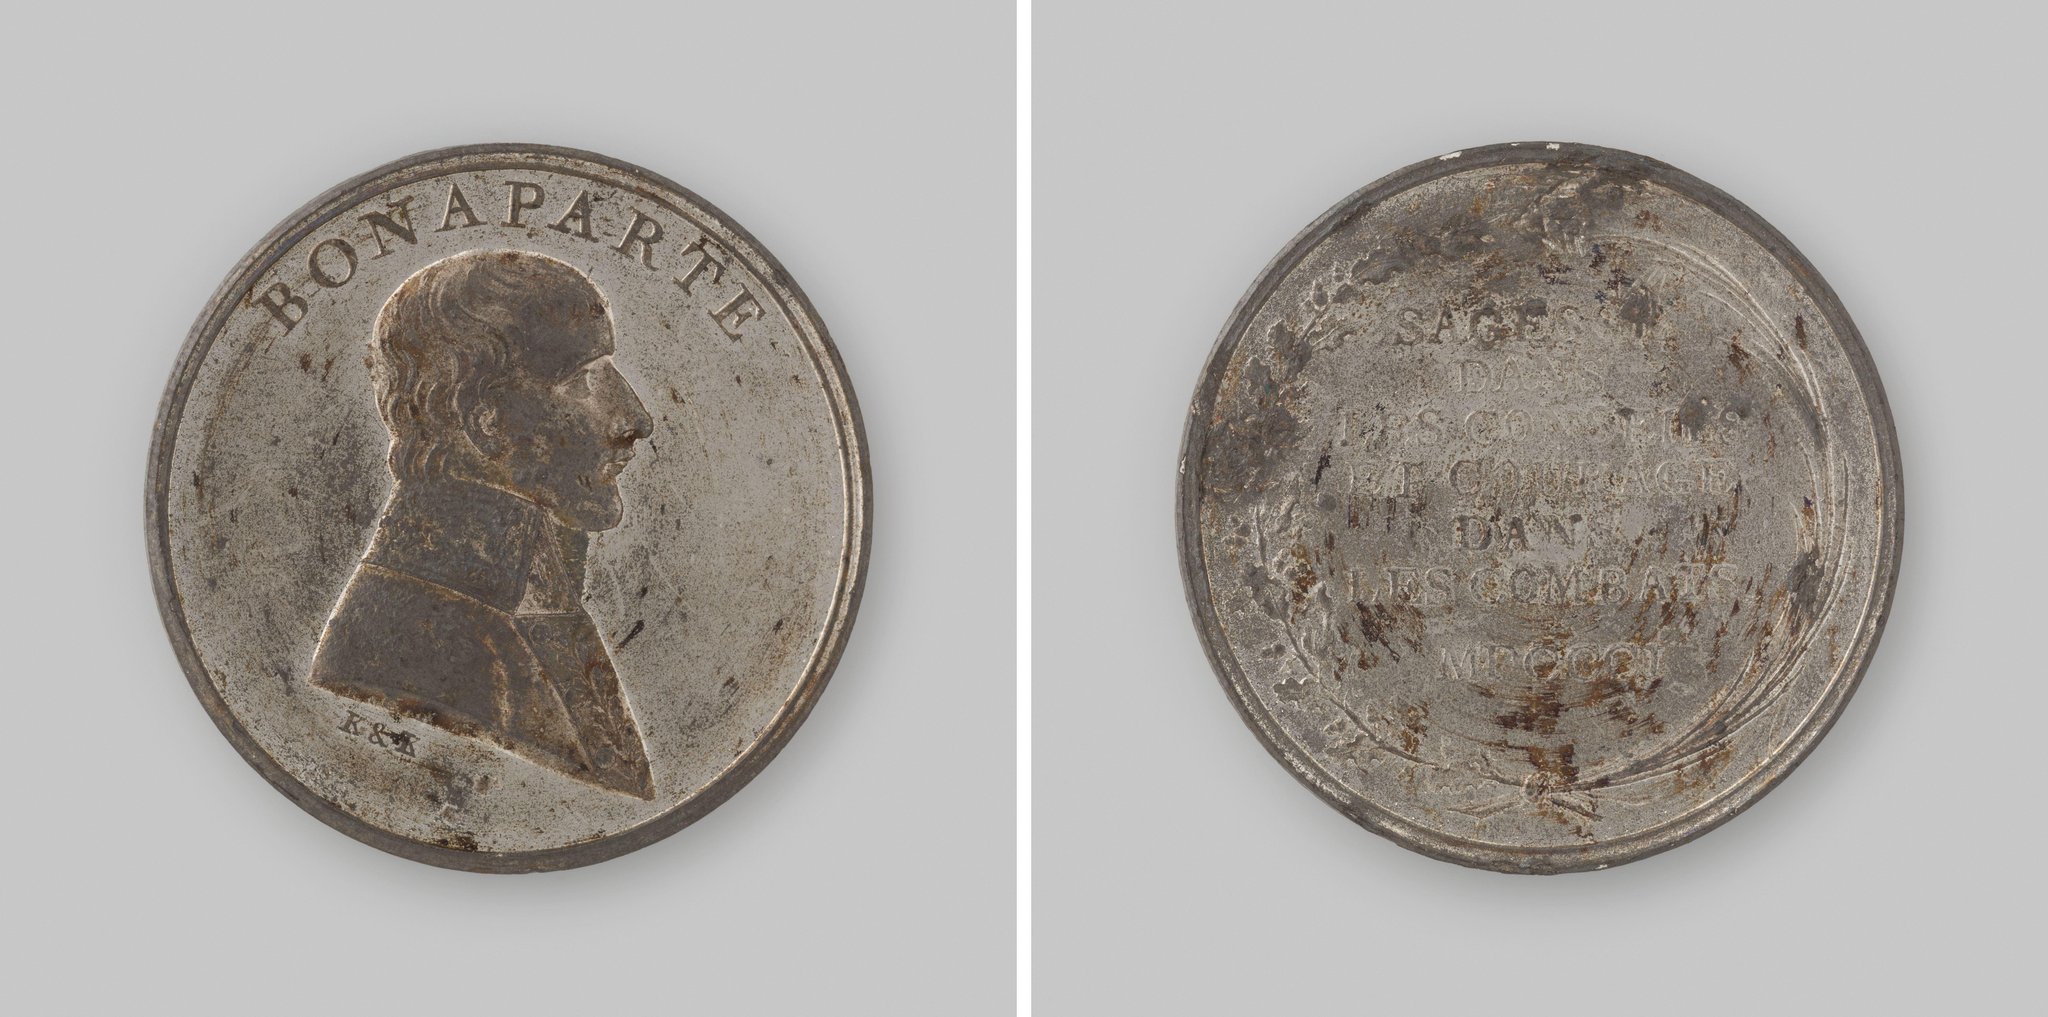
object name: history medal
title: Napoleon Bonaparte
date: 1801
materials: tin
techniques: striking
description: Tinnen penning, op de voorzijde het borstbeeld van Napoleon naar rechts met omschrift, op de keerzijde zeven regels tekst tussen samengestrikte eiken- en palmtakken.